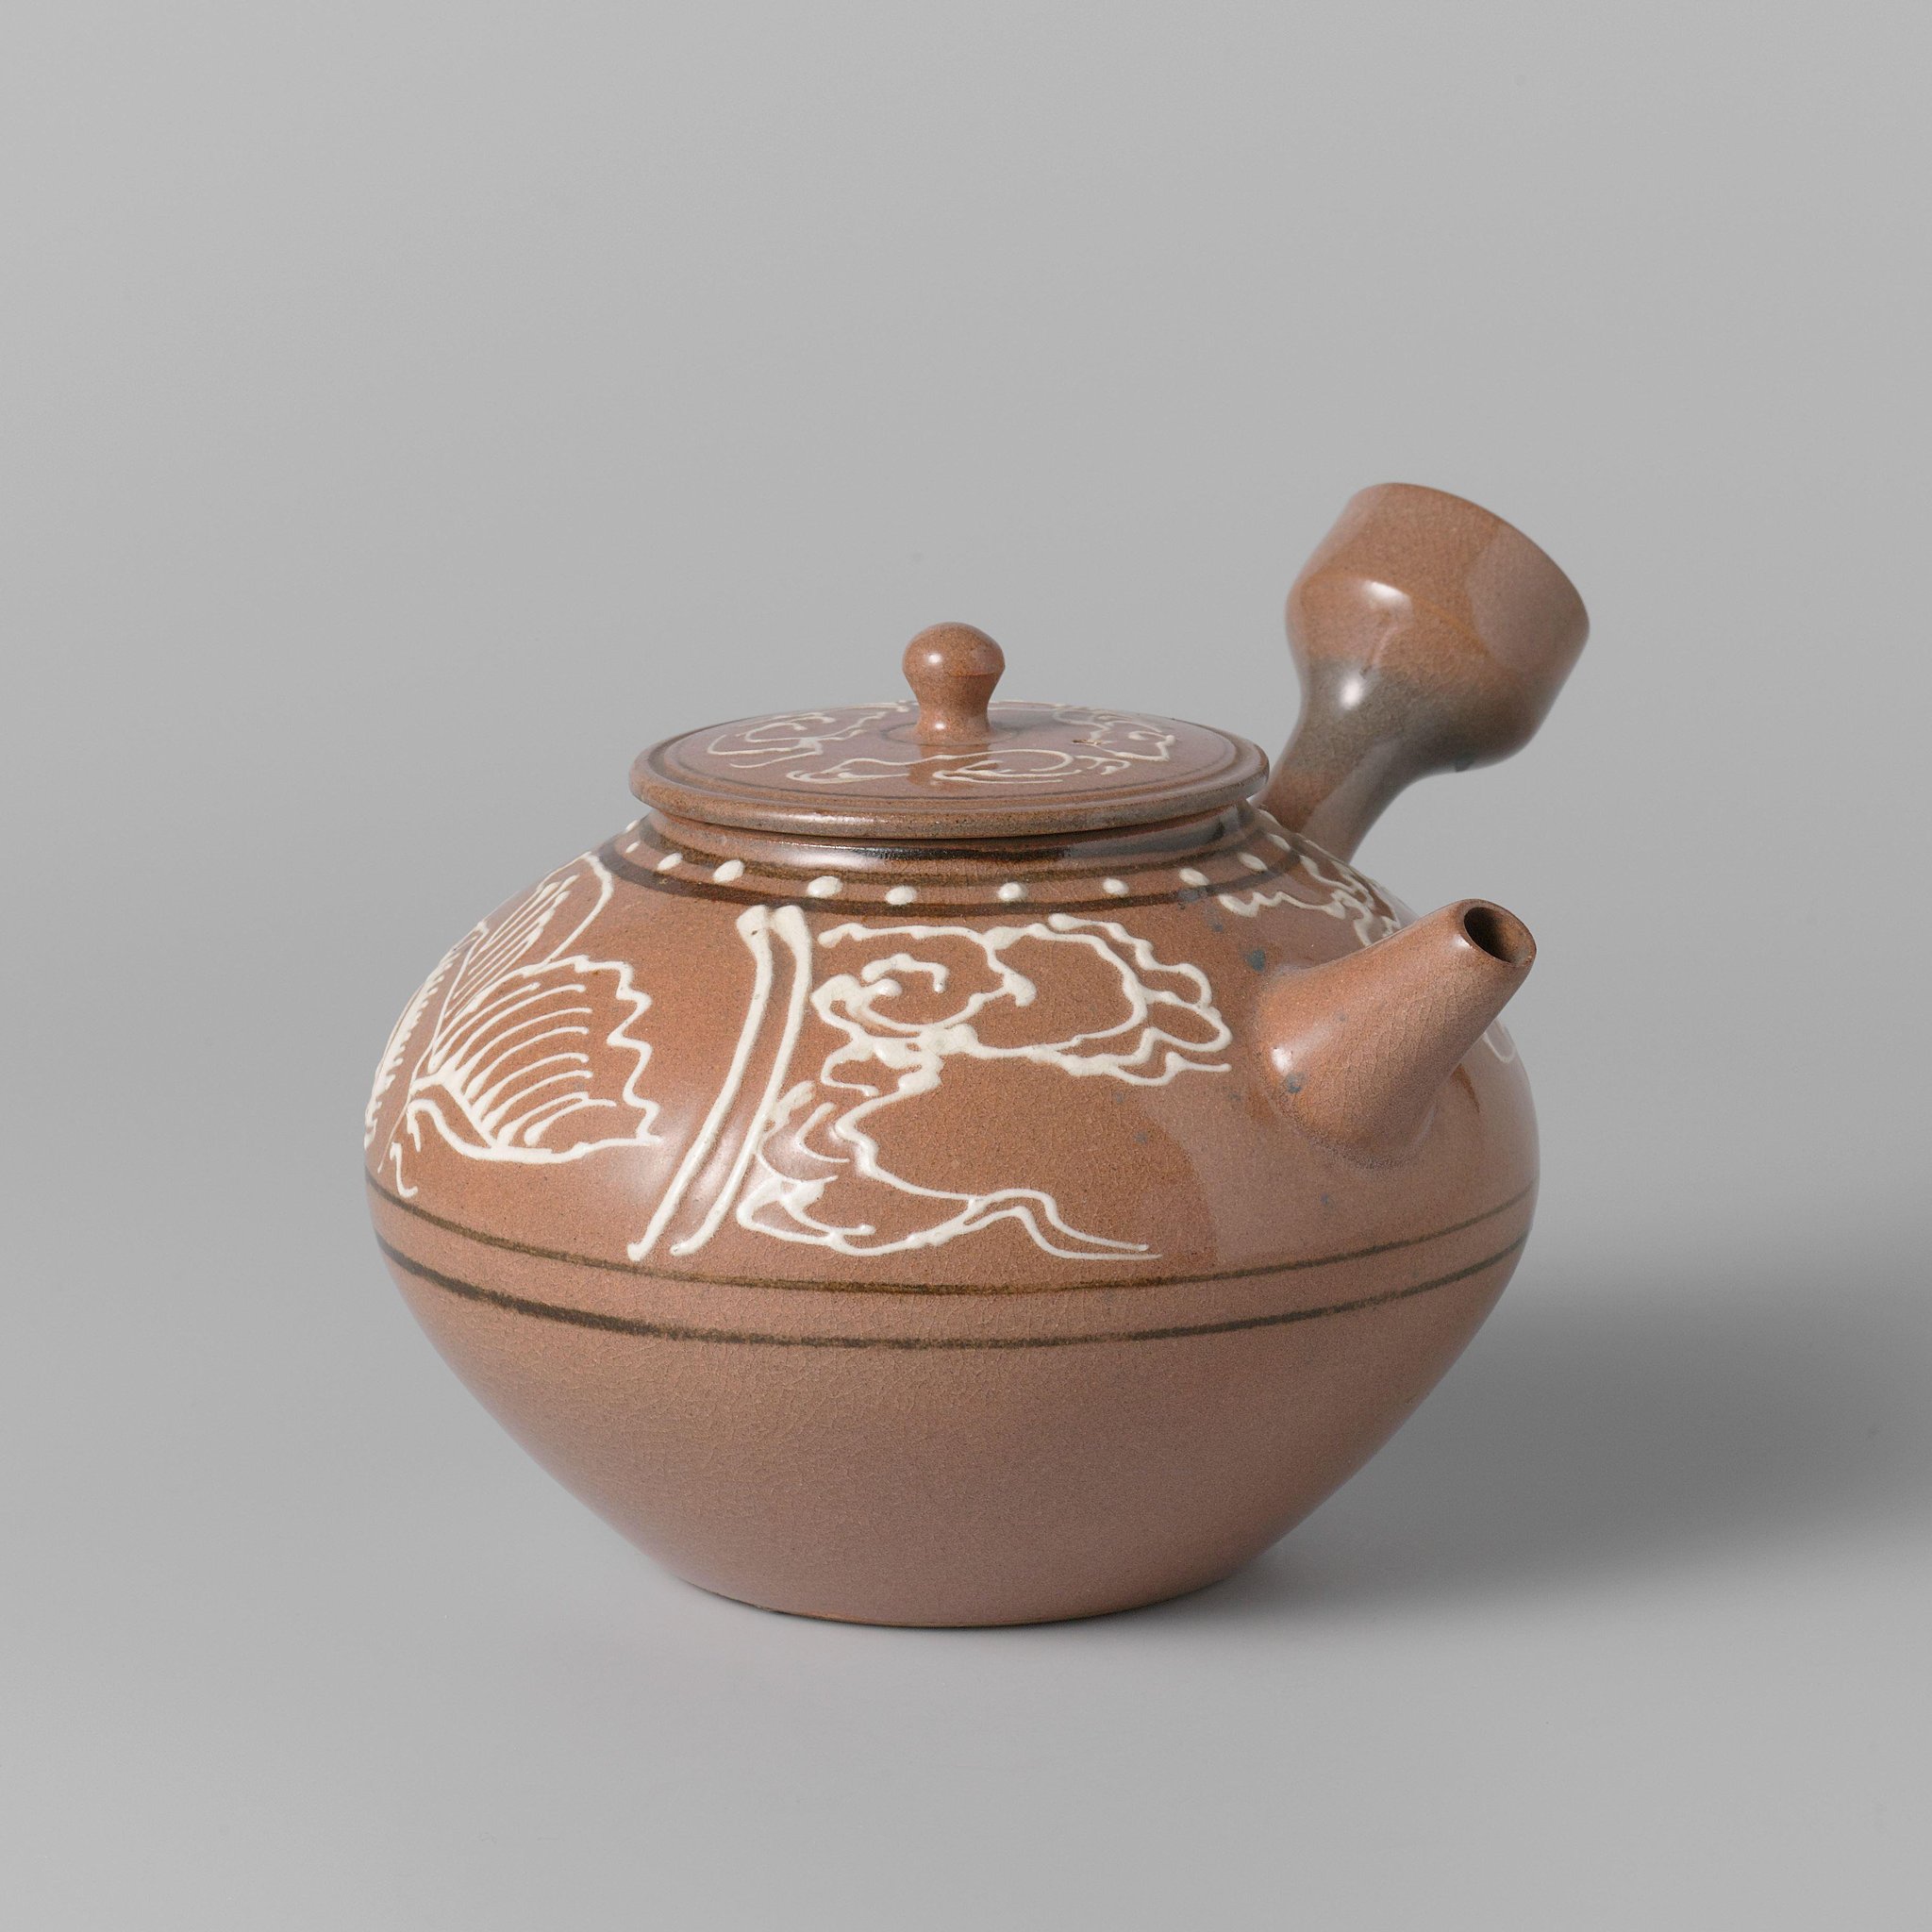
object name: teapot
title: Teapot with flower sprays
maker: Anonymous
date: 1800-1825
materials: glaze, paint, stoneware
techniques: firing, turning, vitrification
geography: japan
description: Kan, met tuit ,oor en deksel, bruin glazuur met witte slib decoratie.